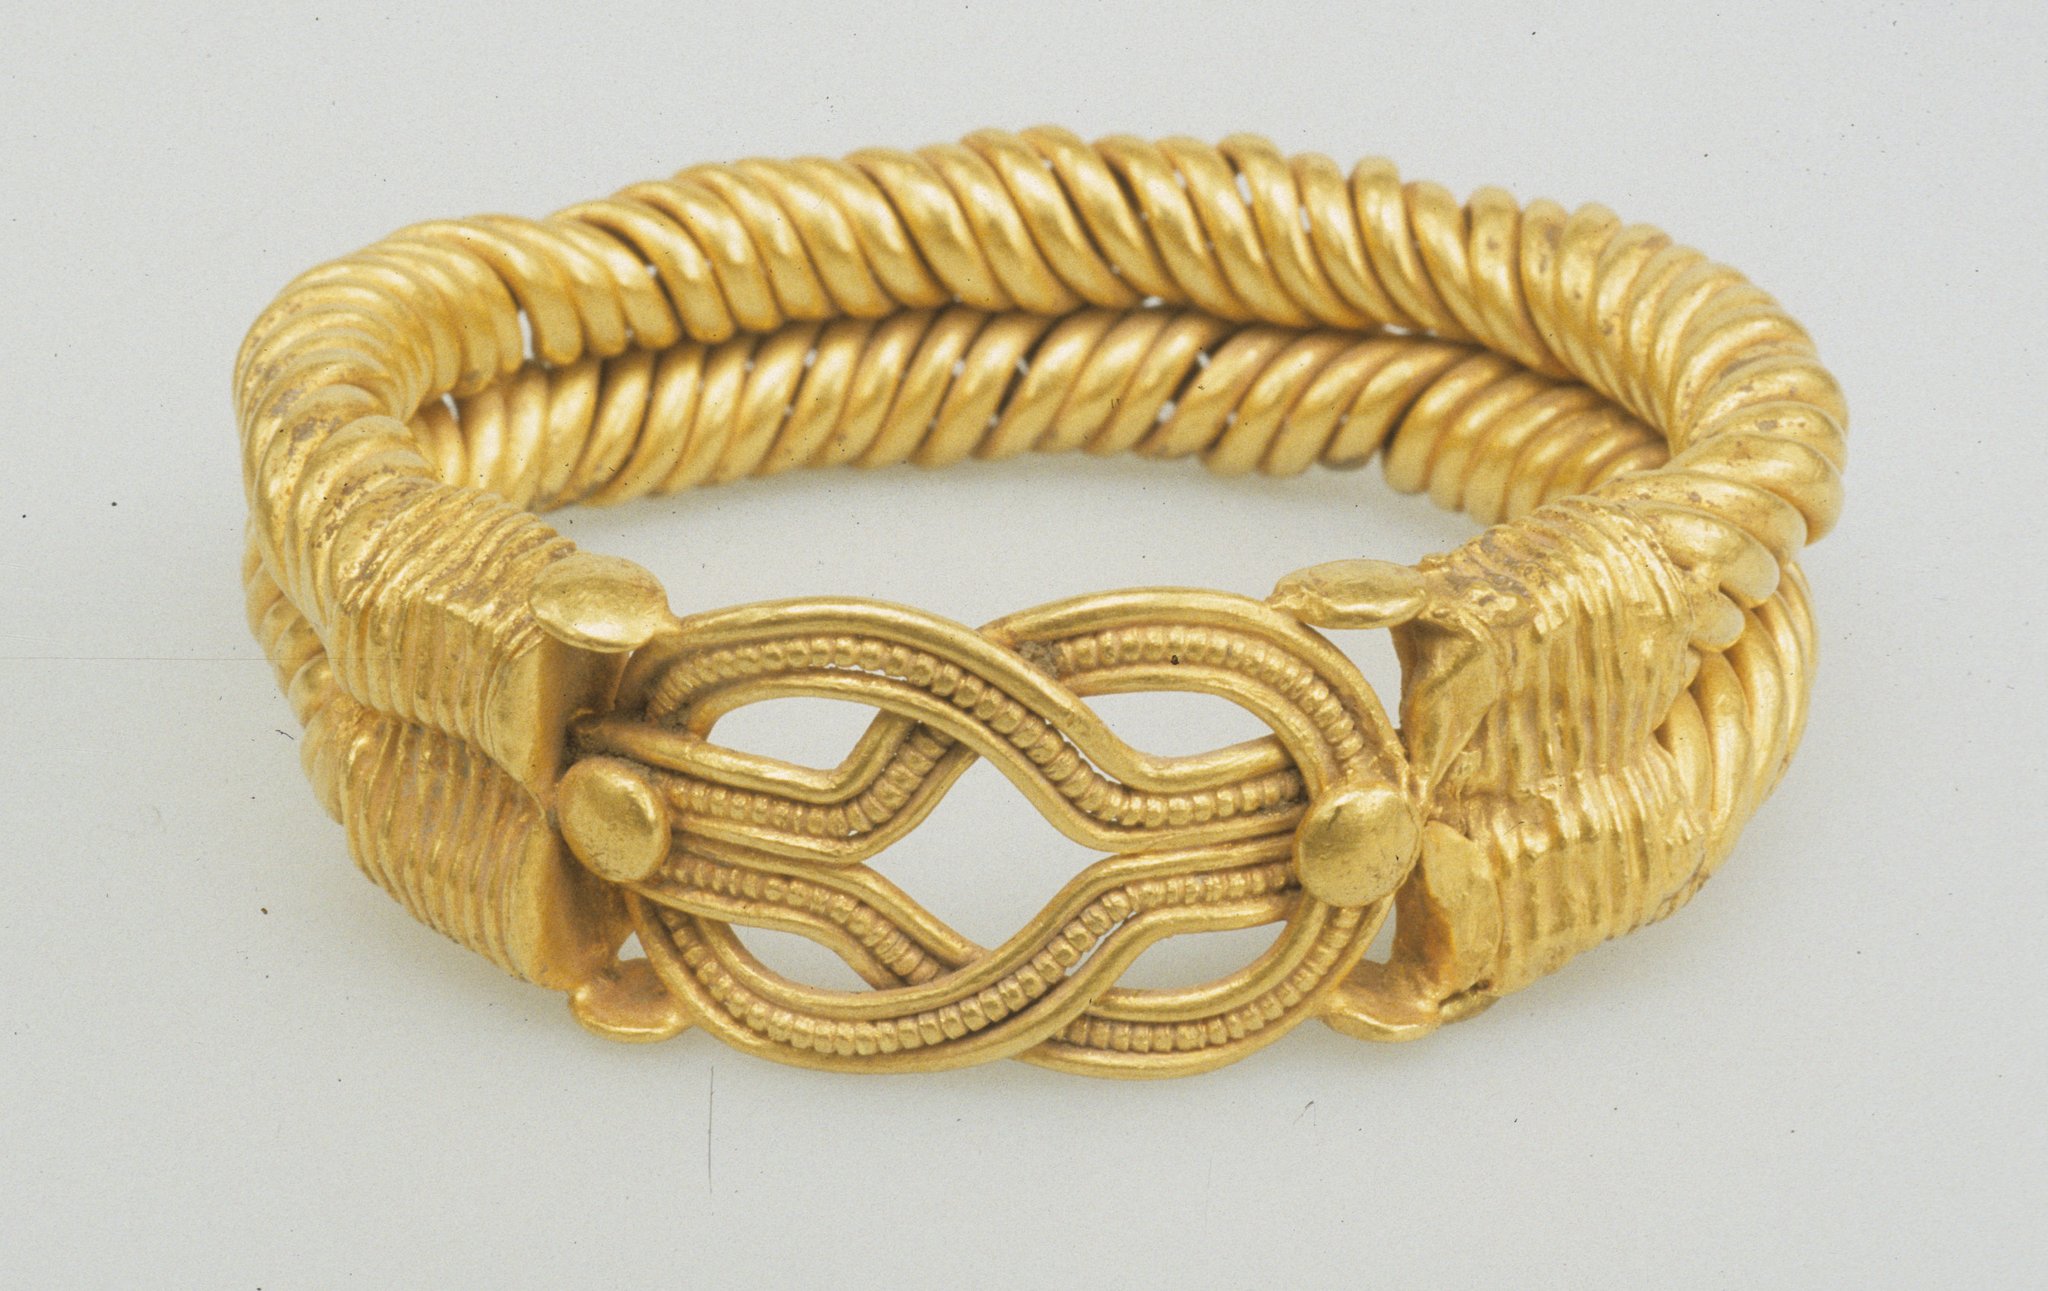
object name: bracelet, herakles knot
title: Bracelet with spirally twisted strands and a Herakles knot at the bezel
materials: gold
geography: lower egypt